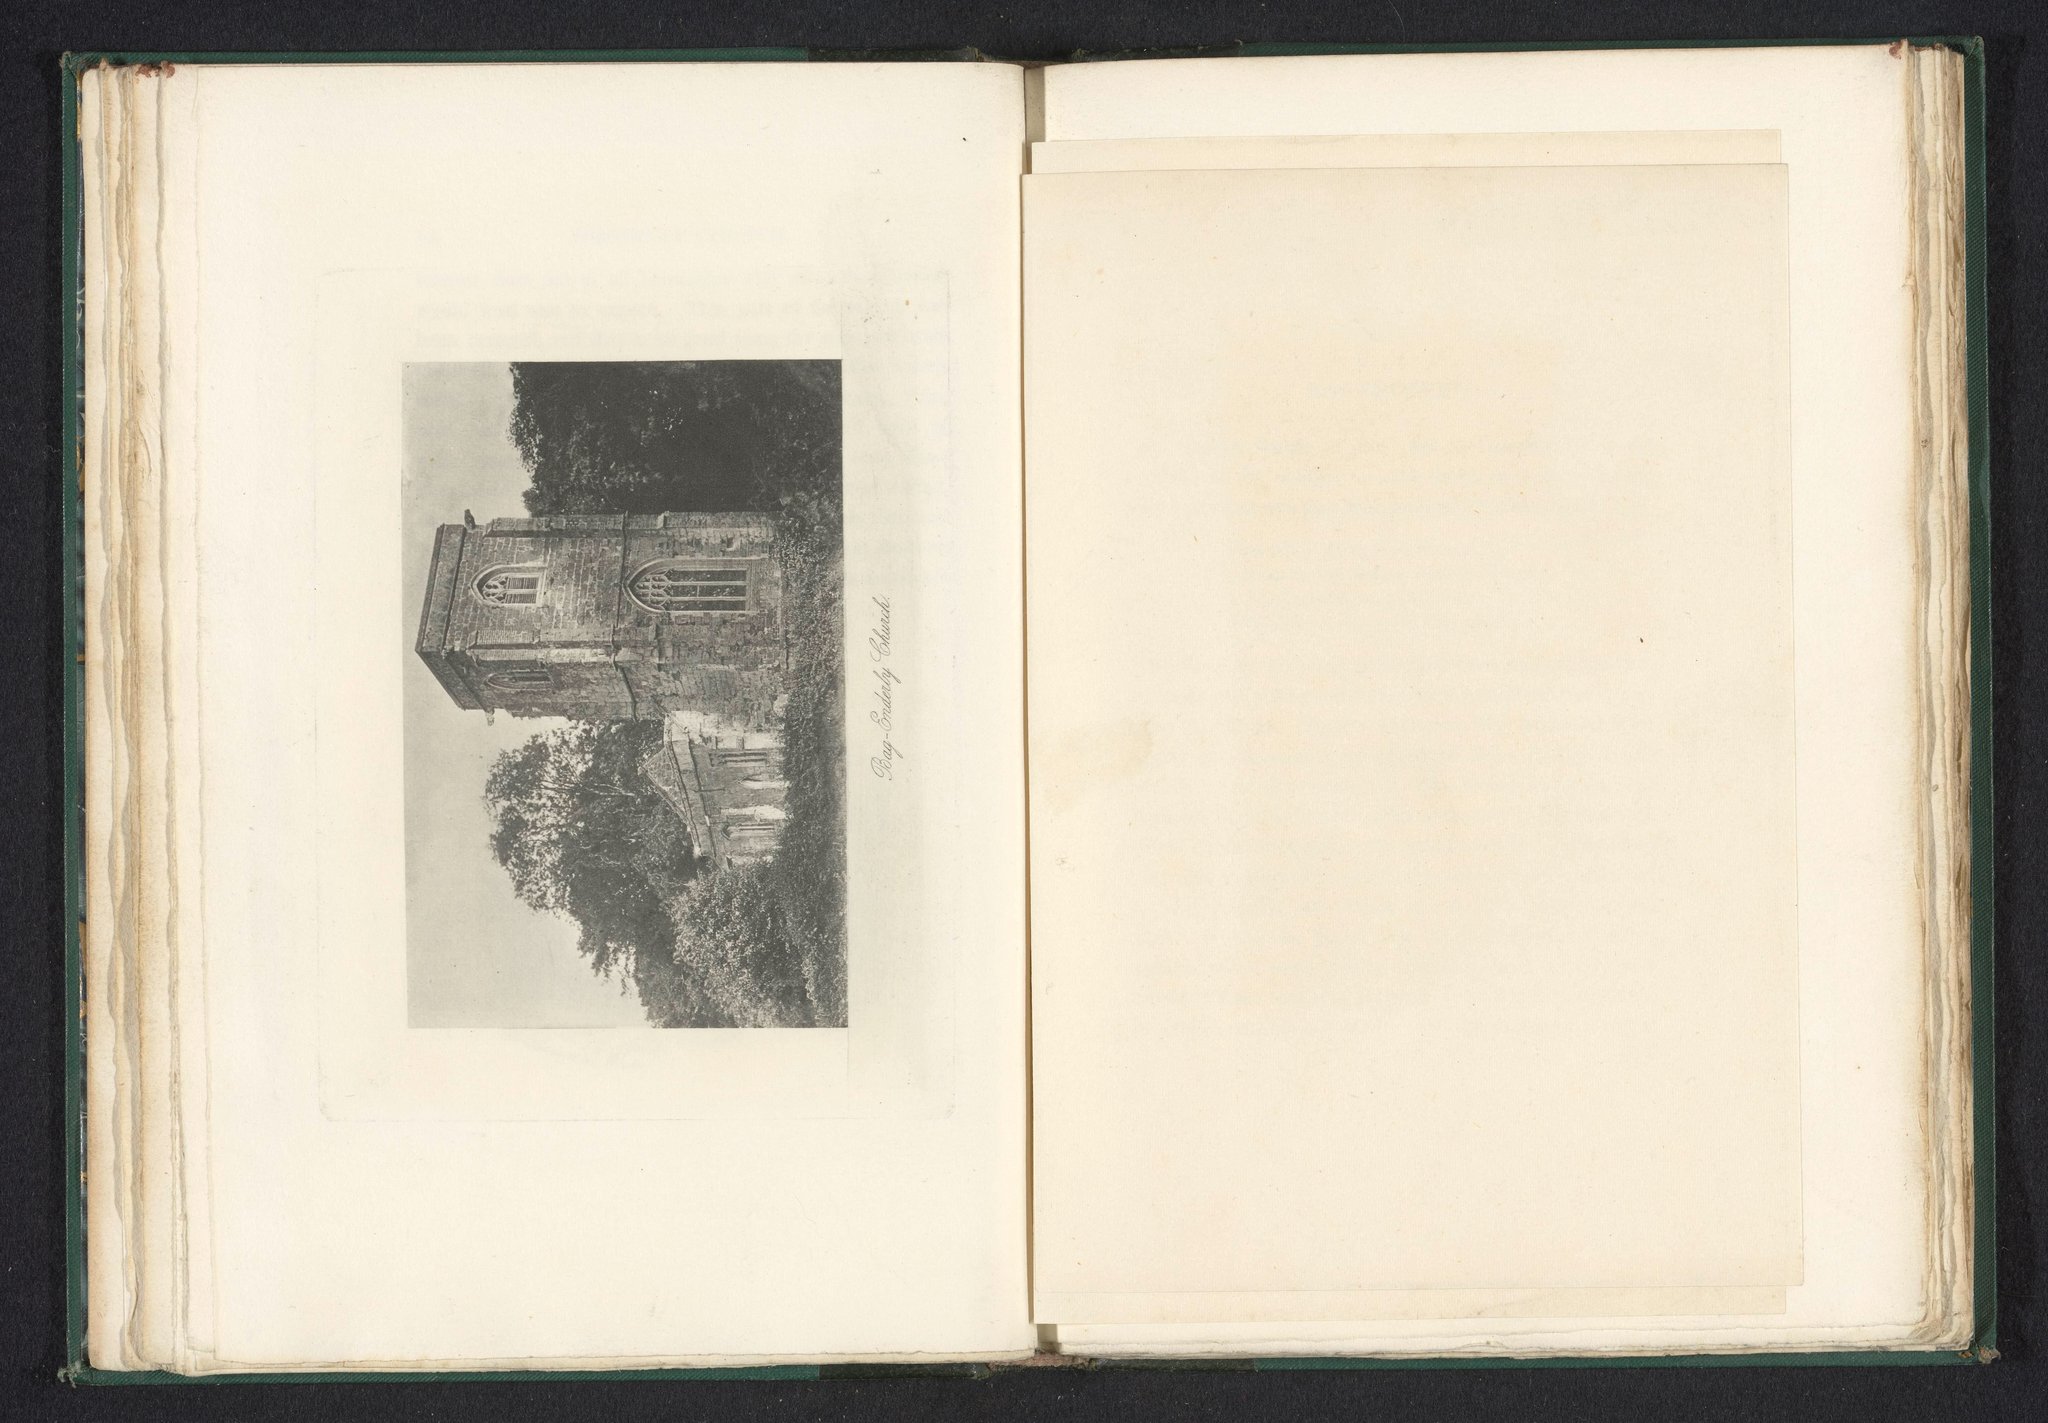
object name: page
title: Bag-Enderby Church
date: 1884-1889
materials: paper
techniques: photoaquatint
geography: glasgow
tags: church (exterior), façade (of house or building)